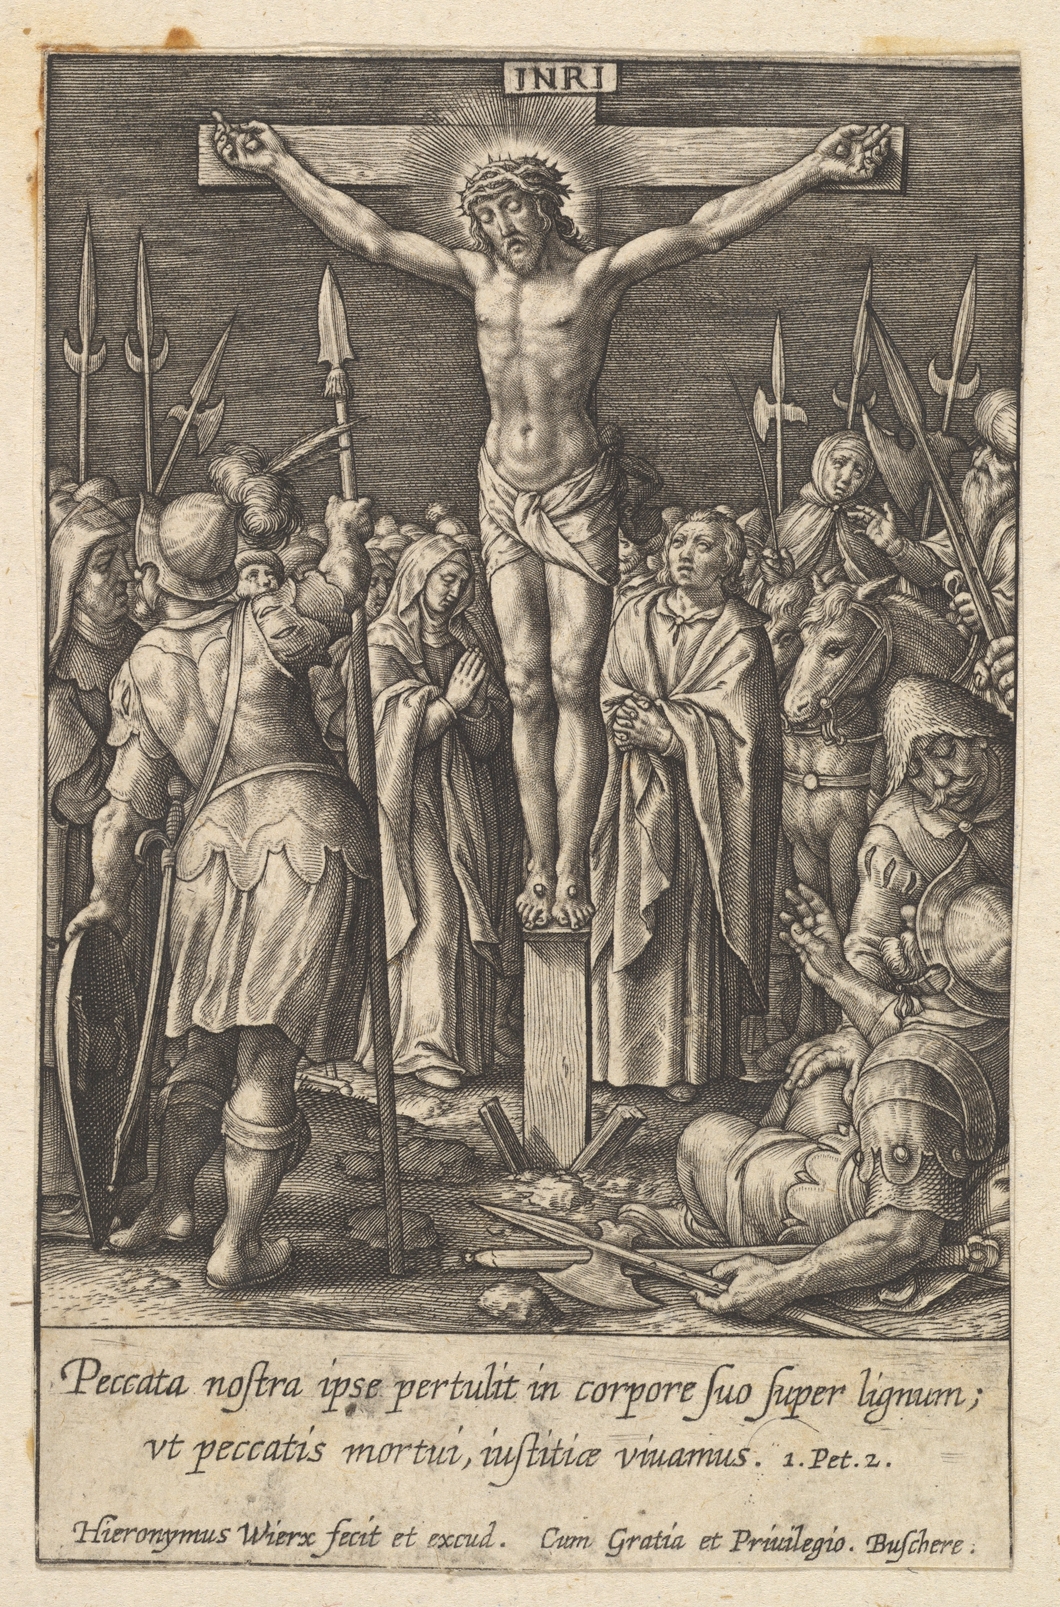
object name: print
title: Christ Crucified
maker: hieronymus wierix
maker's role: artist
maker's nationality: netherlandish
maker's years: 1553-1619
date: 1619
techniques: engraving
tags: men,women,christ,crucifixion